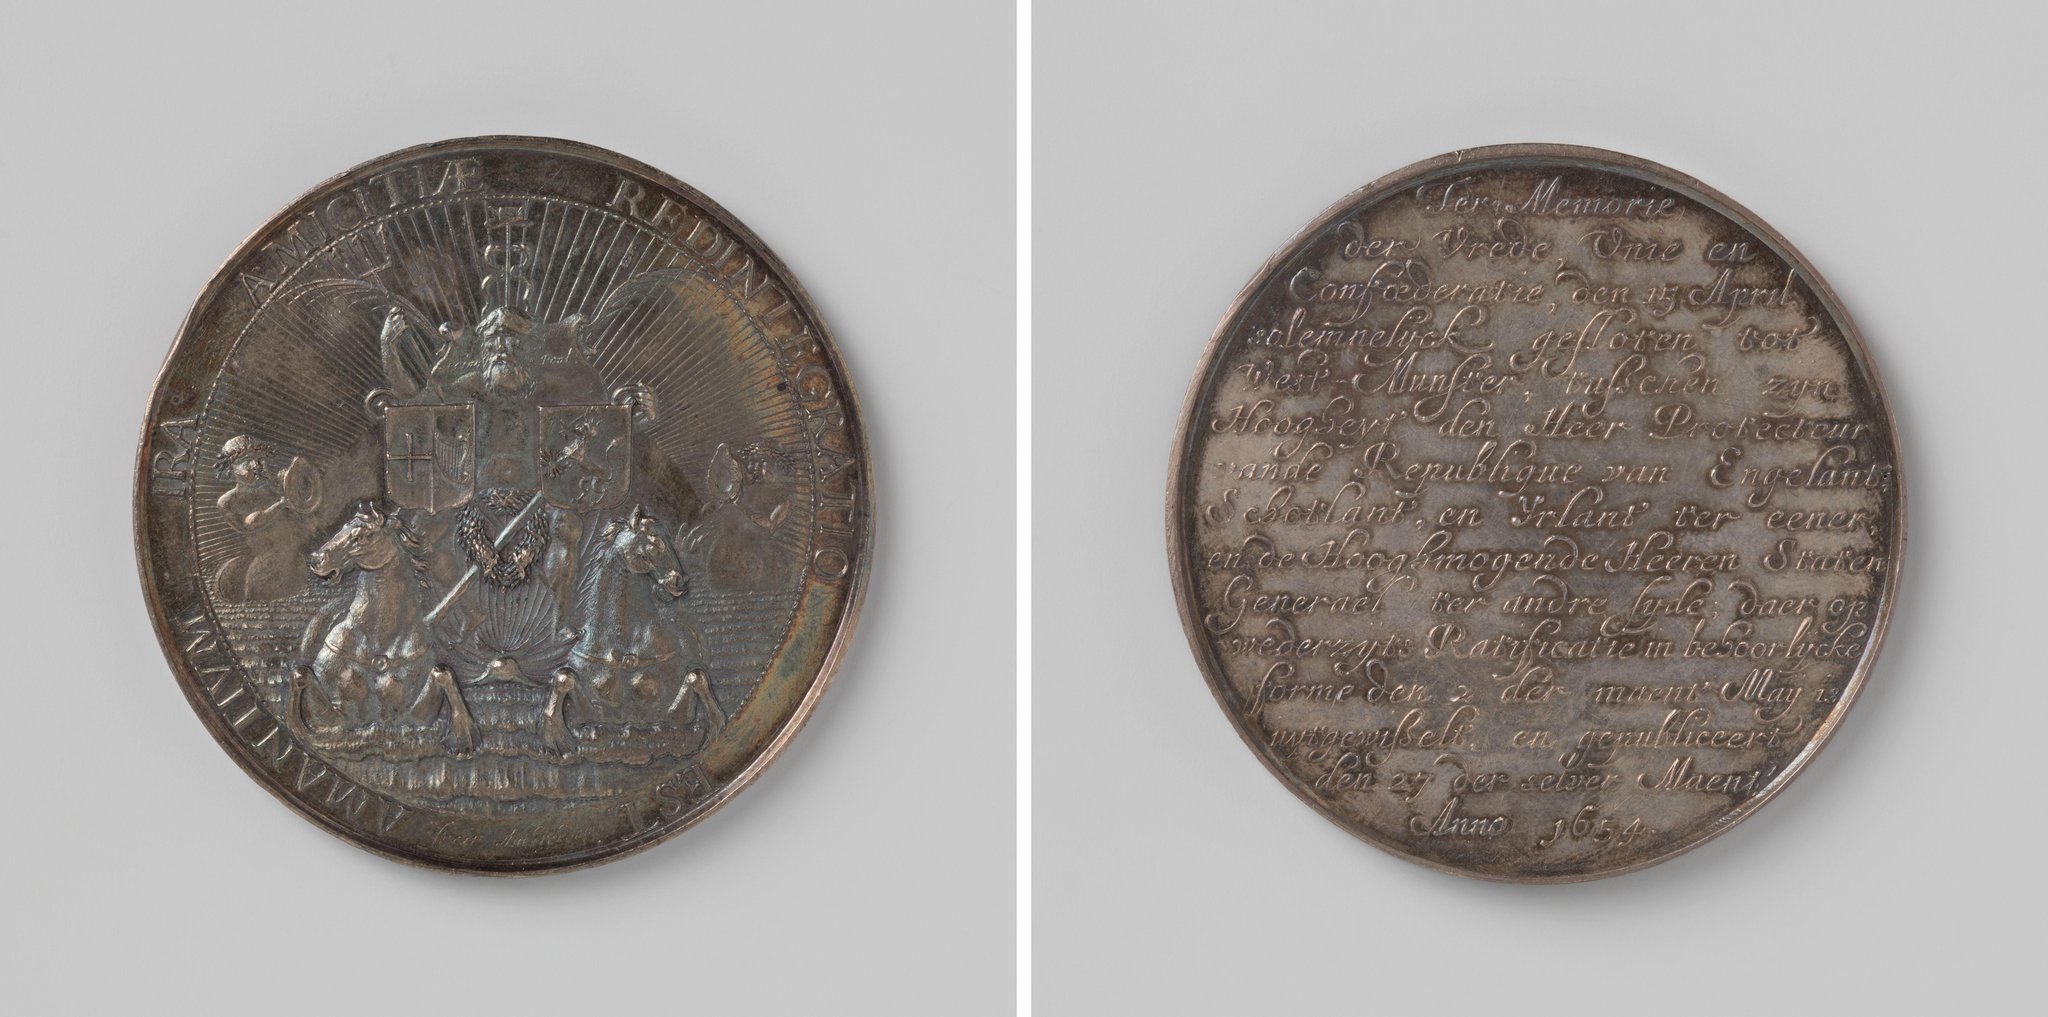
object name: history medal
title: Vrede tussen Engeland en Holland, te Westminster gesloten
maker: juriaen pool (i)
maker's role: medailleur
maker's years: 1618-1669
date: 1654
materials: silver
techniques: striking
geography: amsterdam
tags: netherlands, england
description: Zilveren penning. Voorzijde: Neptunus gezeten op zijn wagen tussen twee tritons die op hoorn blazen, houdt twee wapenschilden binnen omschrift. Keerzijde: opschrift